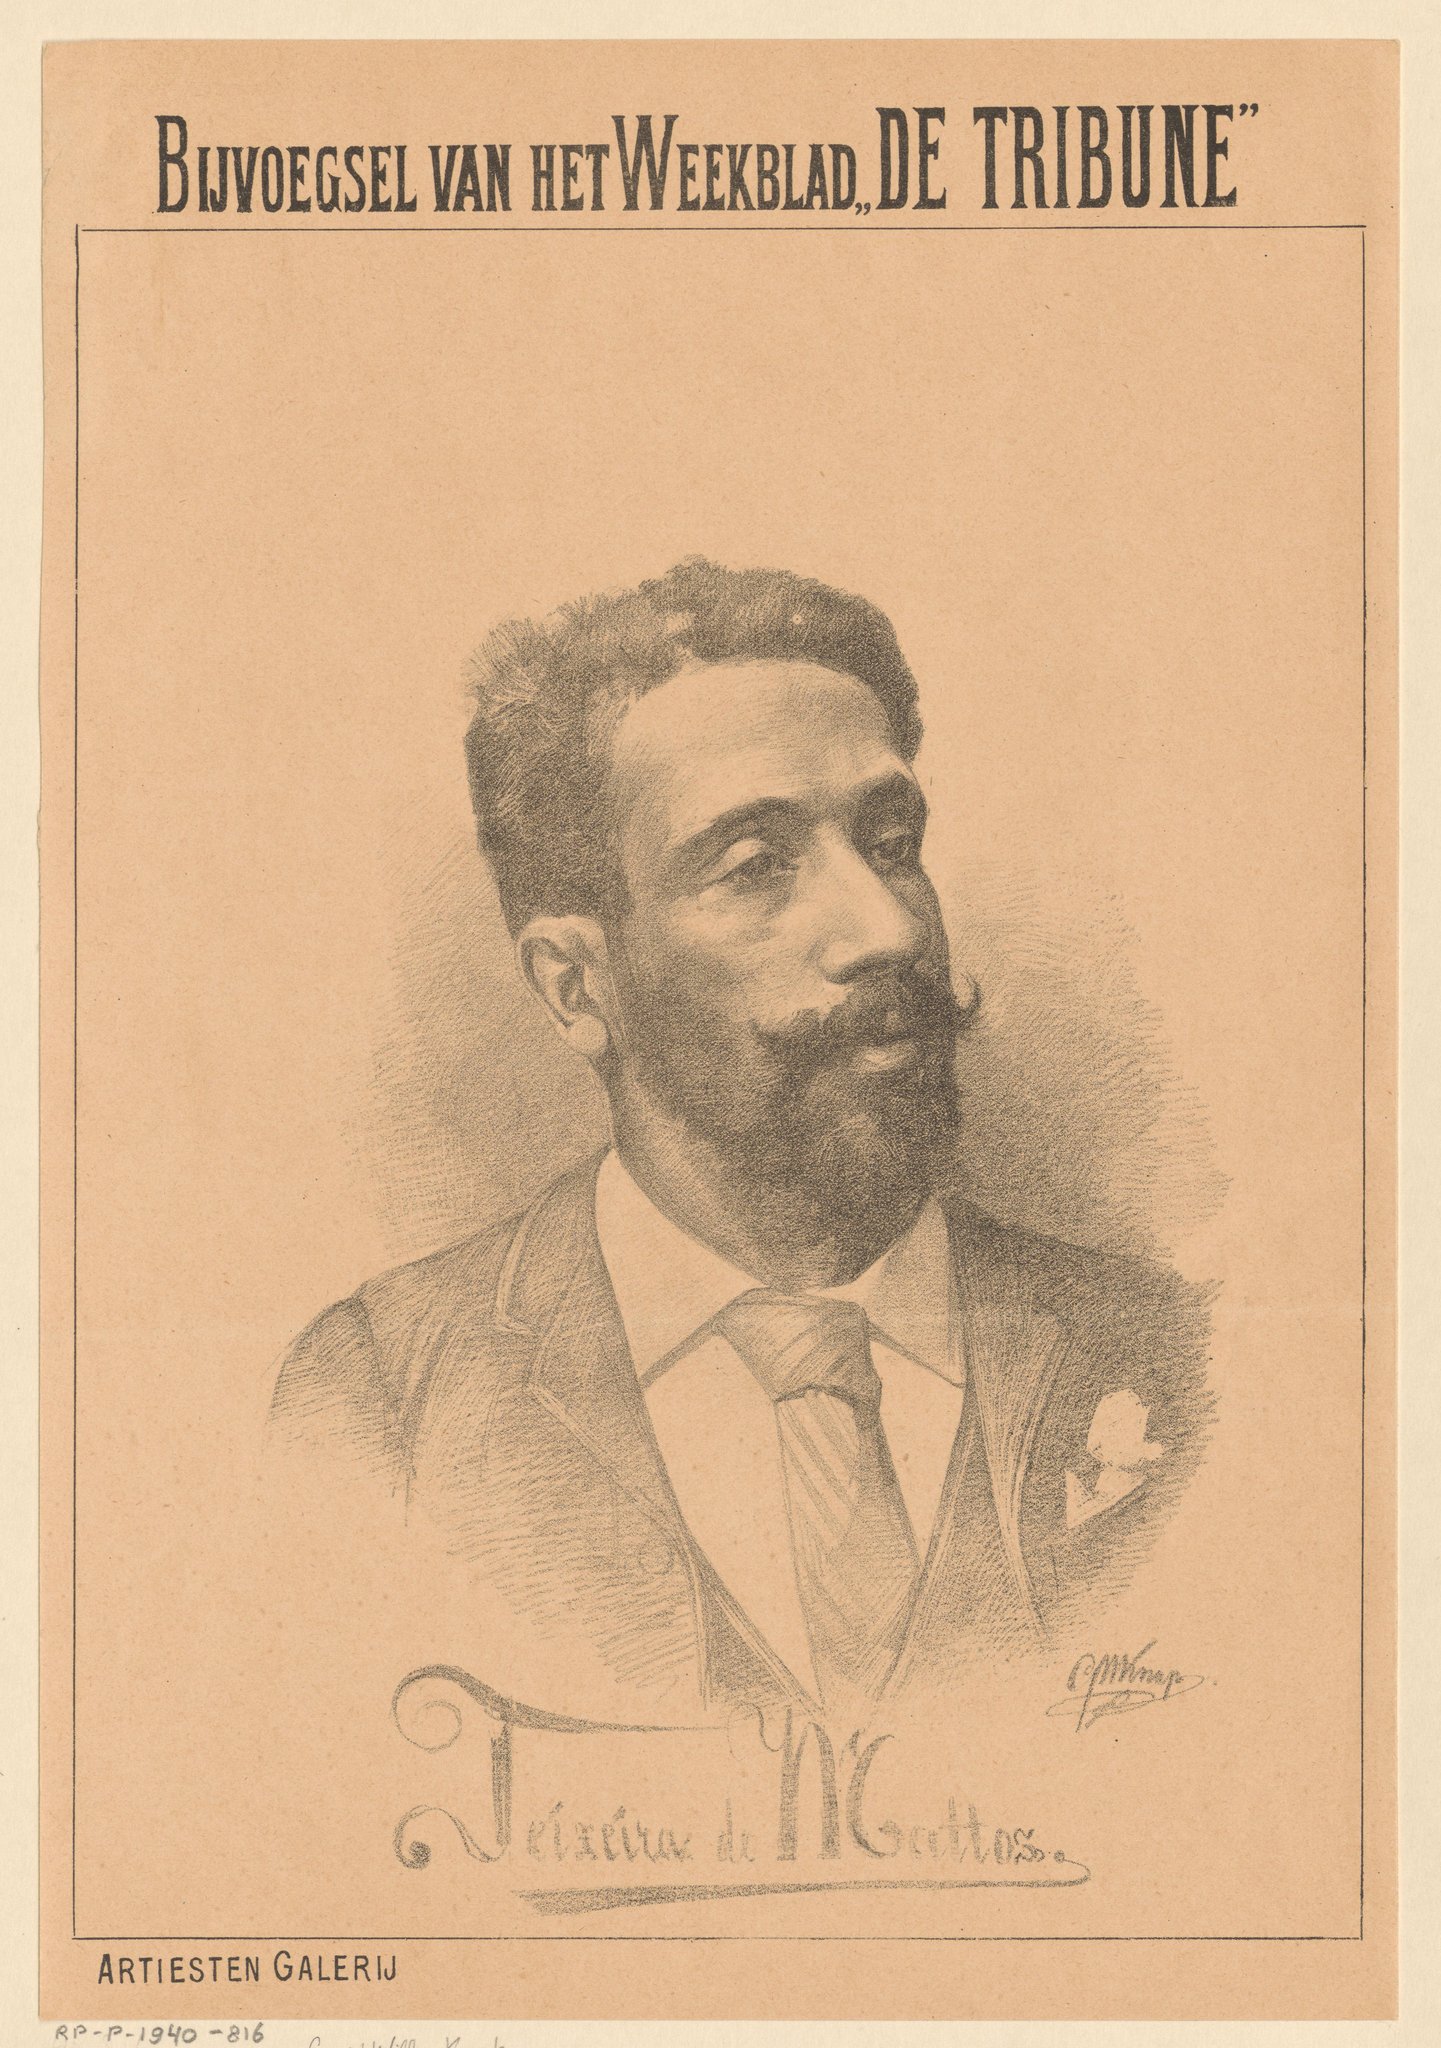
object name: print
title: Portret van Henri Teixeira de Mattos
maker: gerrit willem knap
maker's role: print maker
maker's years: 1873-1931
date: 1883-1931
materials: paper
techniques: lithograph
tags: amsterdam, the hague, painter, sculptor, henri teixeira de mattos, portrait, self-portrait of sculptor, historical persons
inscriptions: collector's mark: Lugt 2760, collector's mark: Lugt 2228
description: Verschenen in het bijvoegsel van 'De Tribune'.